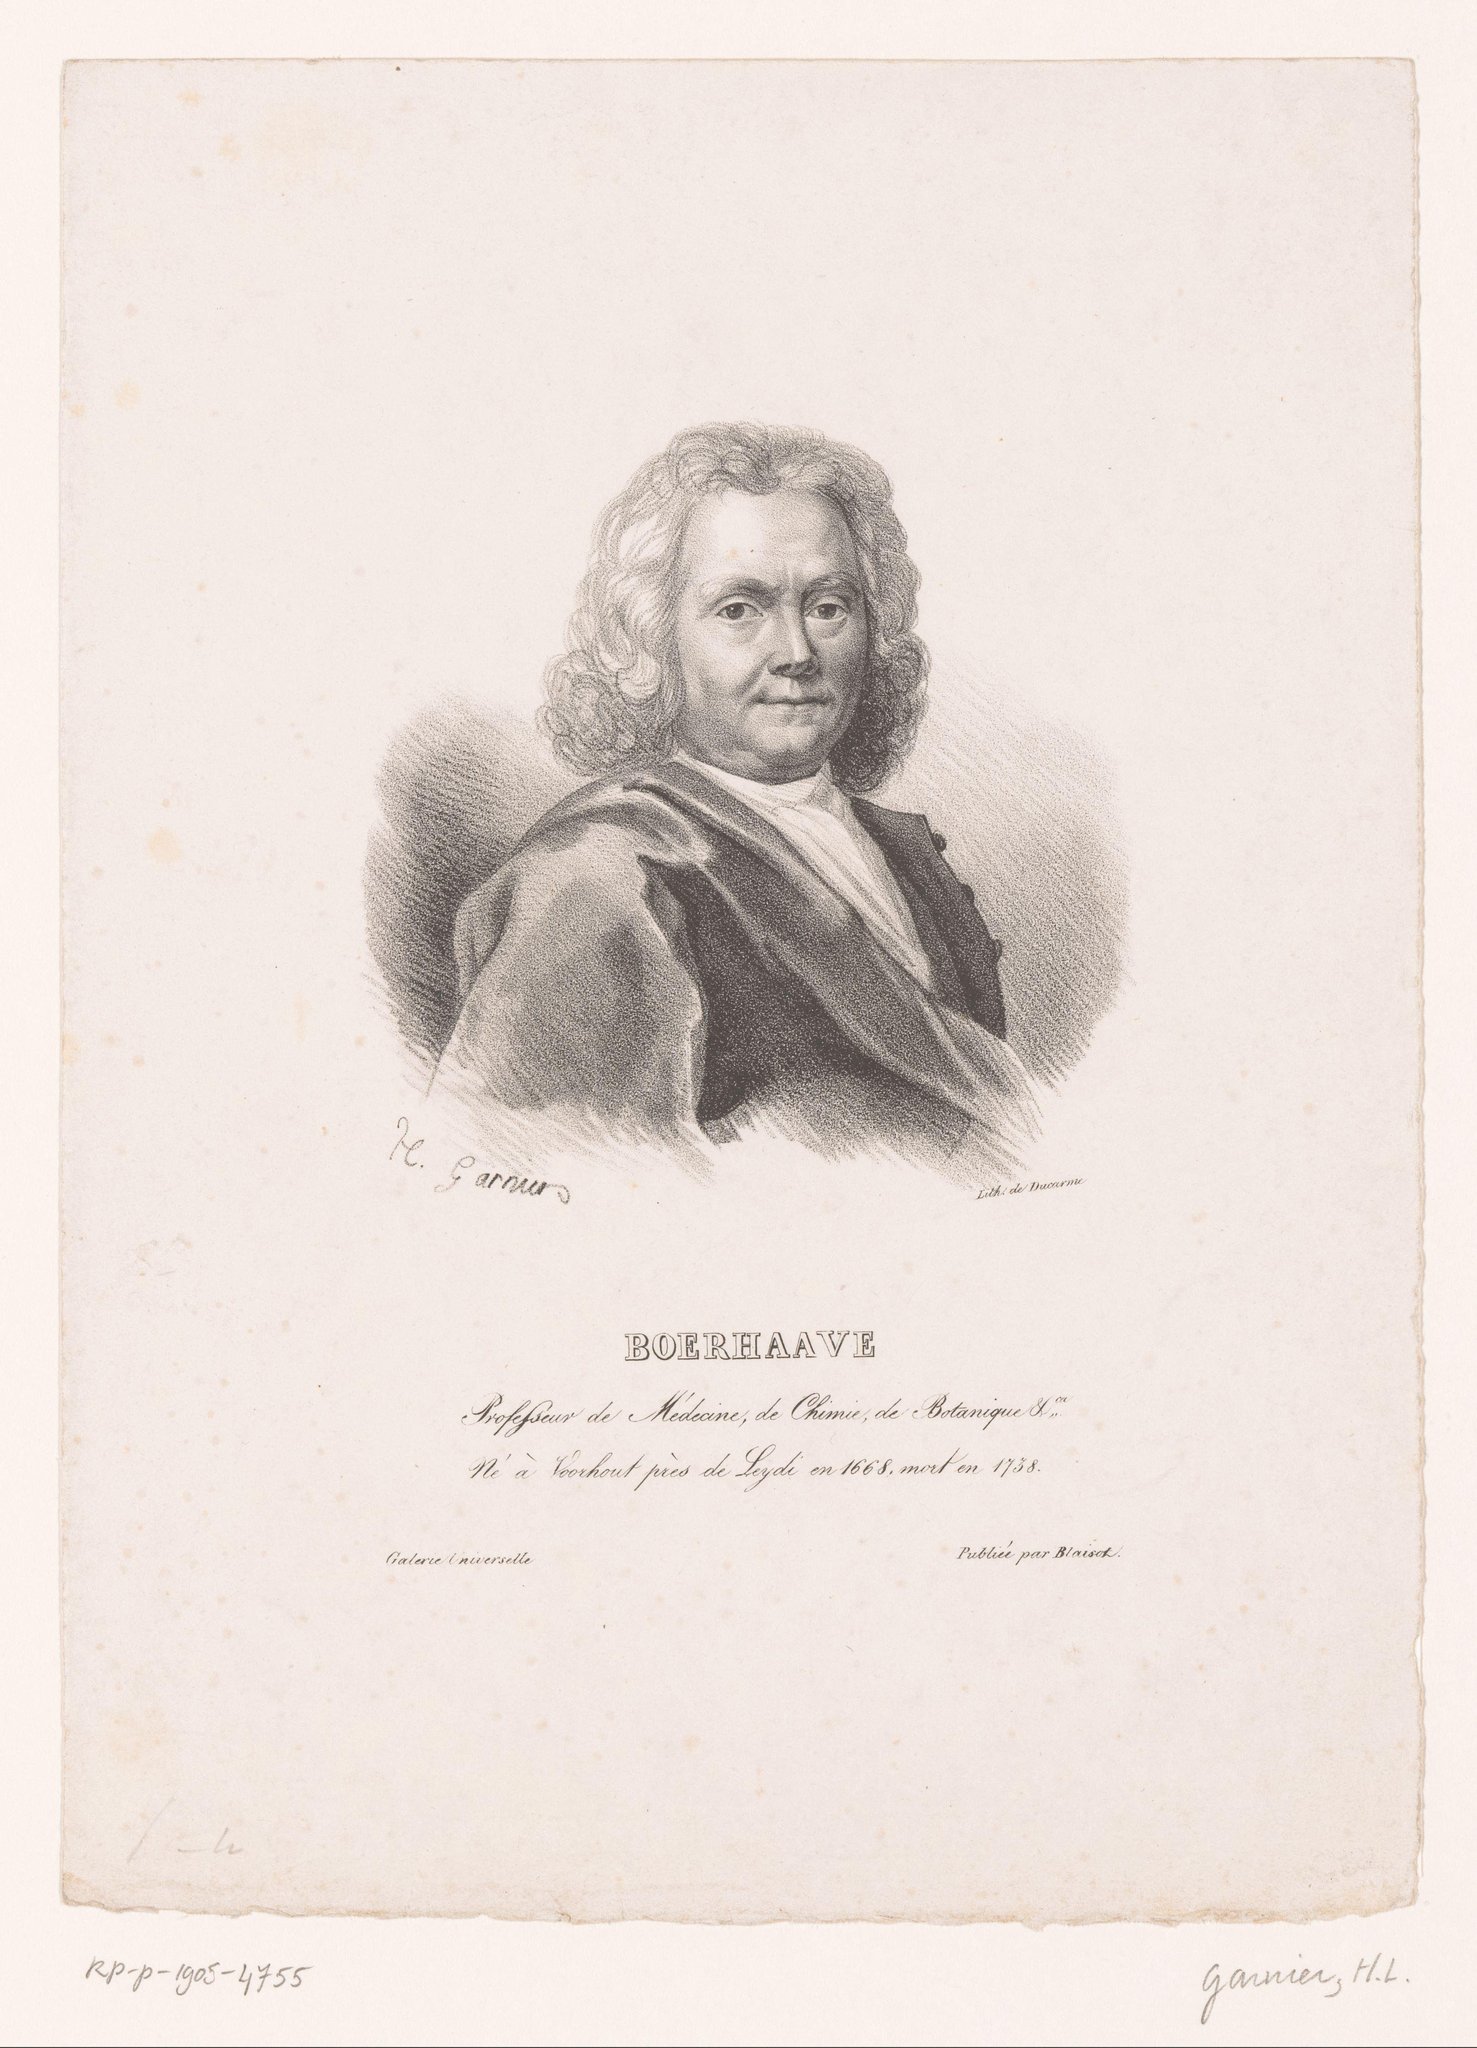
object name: print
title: Portrettengalerij van Blaisot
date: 1823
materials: paper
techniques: lithograph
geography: paris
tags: leiden, hermanus boerhaave, historical persons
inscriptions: collector's mark: Lugt 2228a